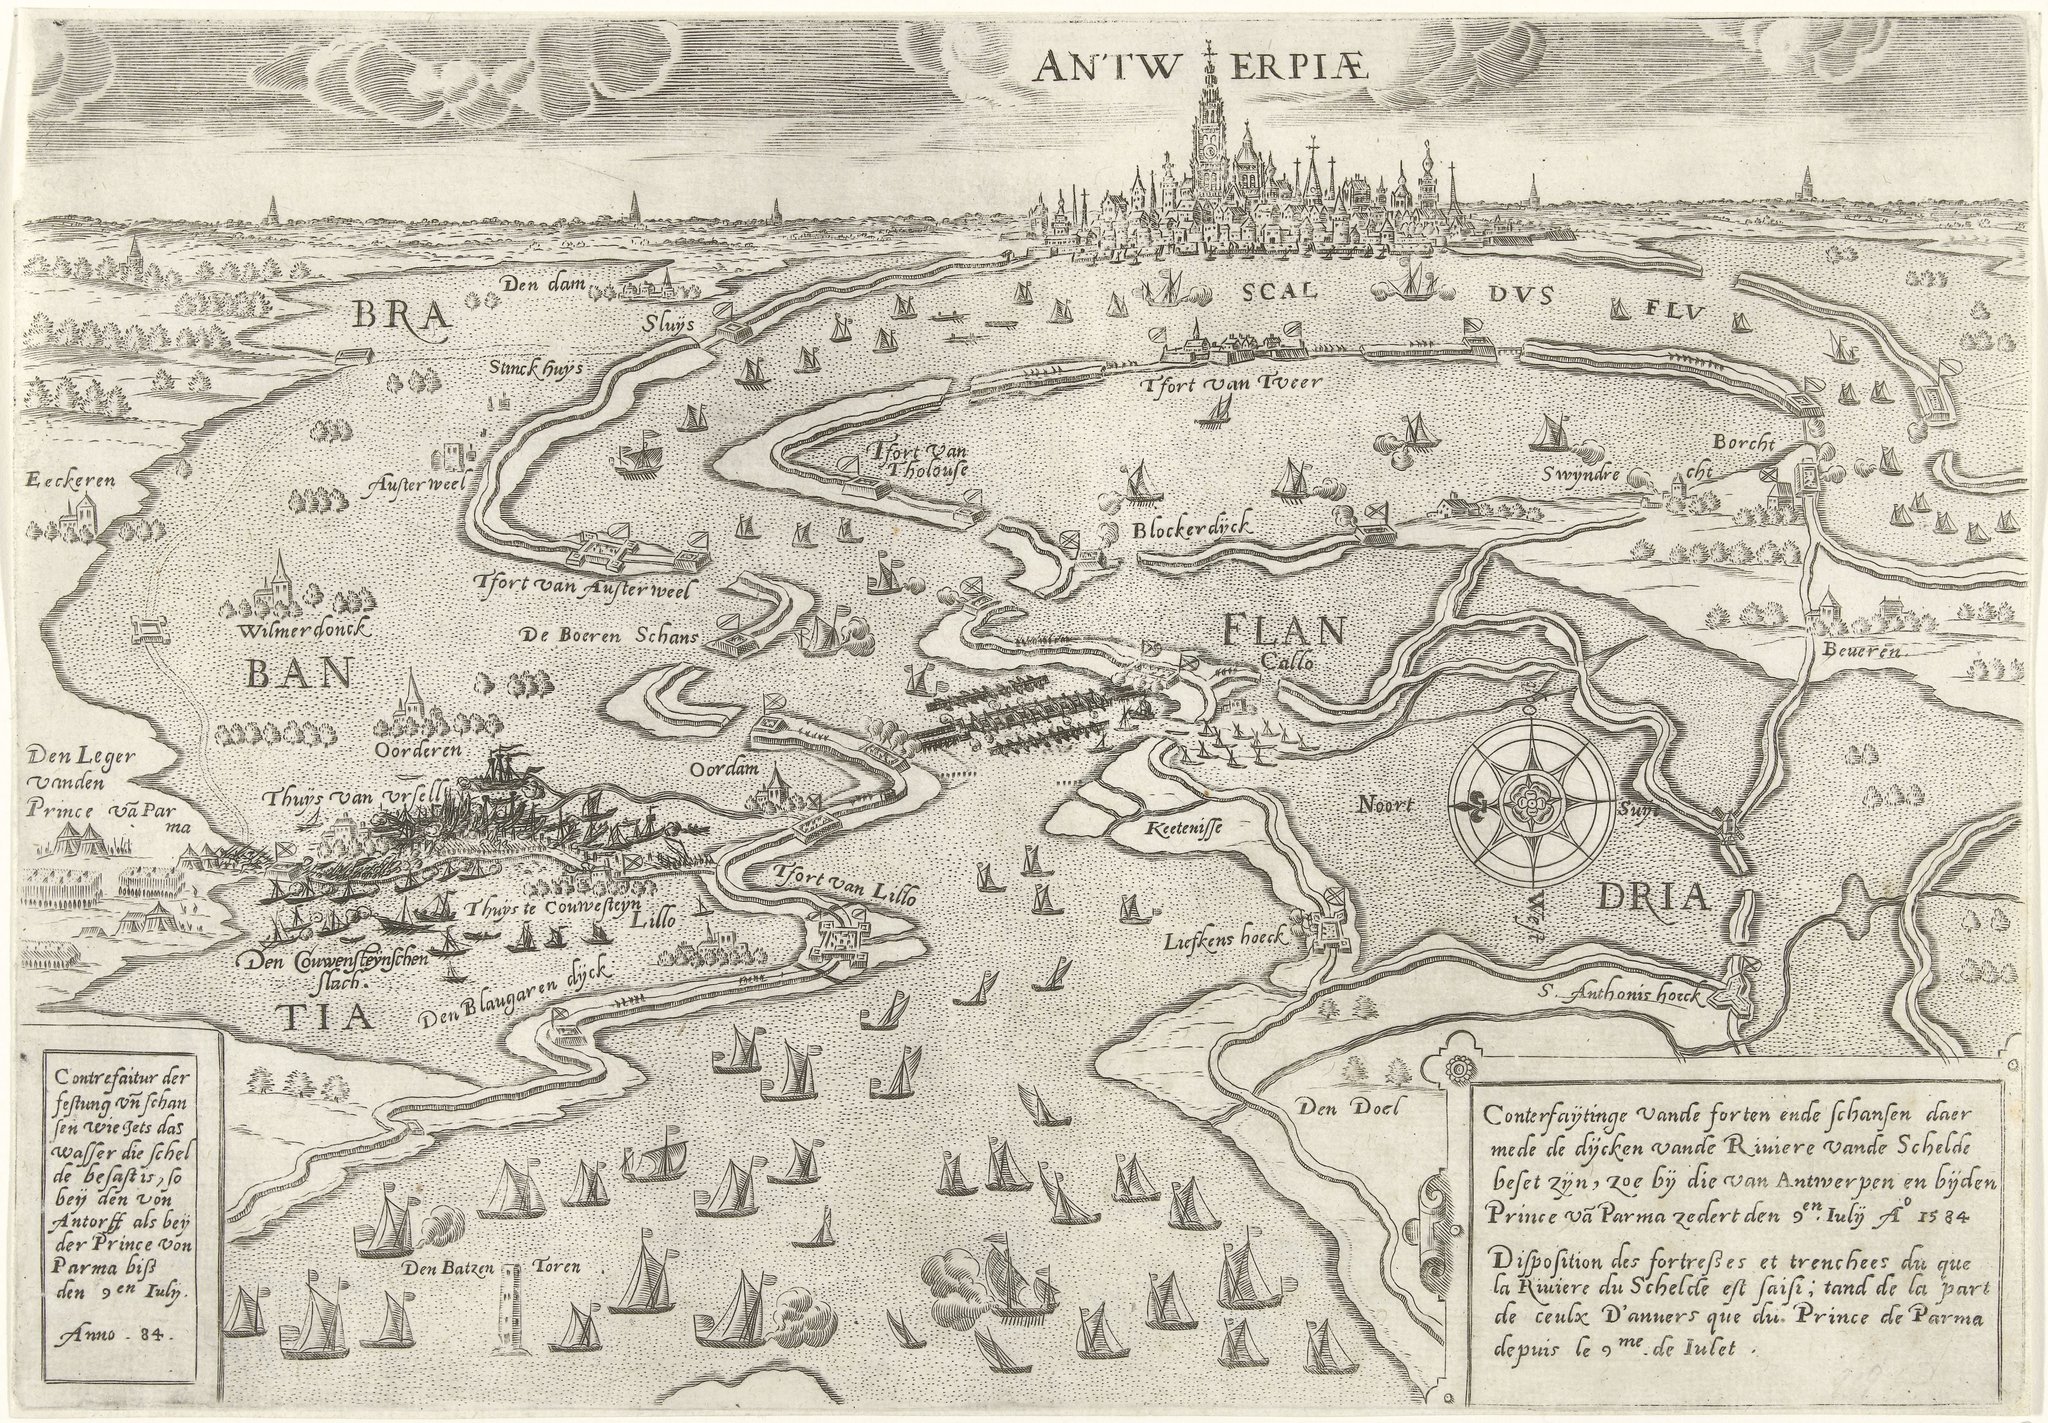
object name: print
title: Dijken doorgestoken bij Antwerpen, 1585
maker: Anonymous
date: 1585-1599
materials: paper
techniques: engraving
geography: cologne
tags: rome, alessandro farnese (landvoogd van de nederlanden en hertog van parma en piacenza), dike-break, battle, antwerp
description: Dijken doorgestoken bij Antwerpen, 26 mei 1585. Gezicht op het ondergelopen gebied rond de stad Antwerpen en de strijd om de Kauwensteinse dijk tussen het leger van Parma en het Staatse leger tijdens het beleg van Antwerpen. Rechtsonder een cartouche met de titels in Nederlands en Frans en linksonder een cartouche met de titel in het Duits.